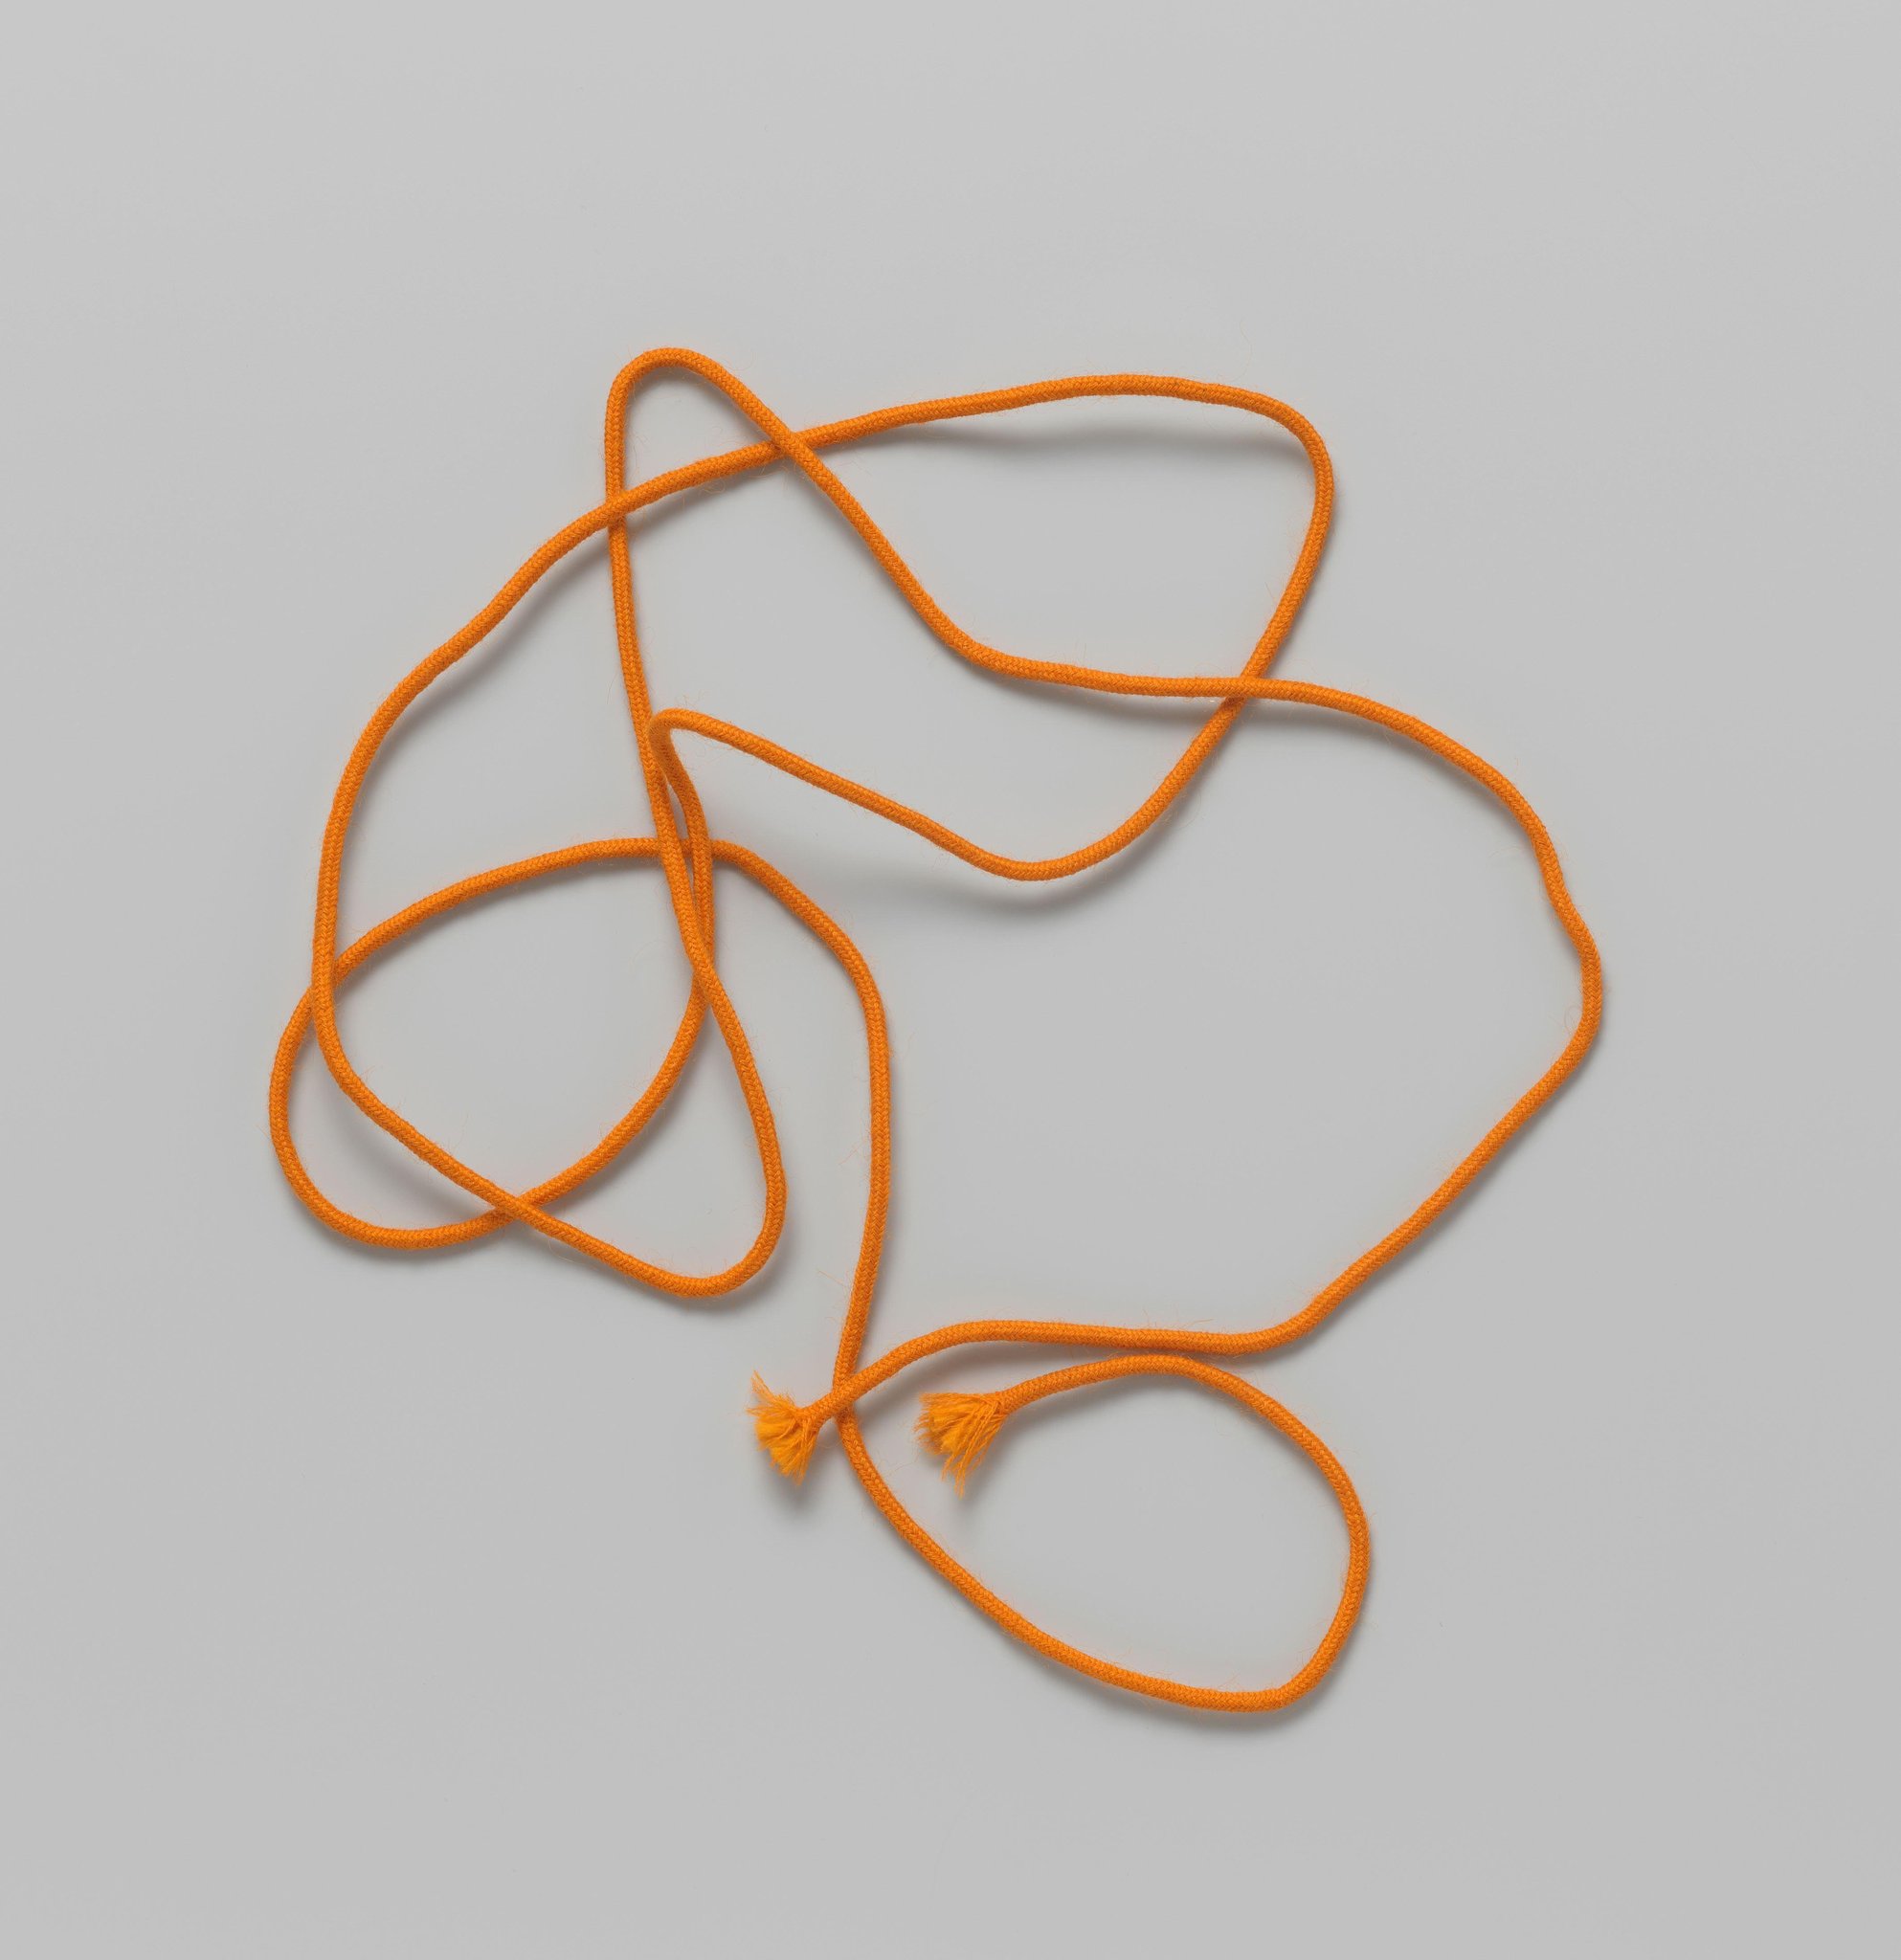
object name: menswear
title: Koord van oranje katoen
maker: Anonymous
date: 1875-1890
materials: cotton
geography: netherlands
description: Koord van oranje katoen, mogelijk herenkleding.